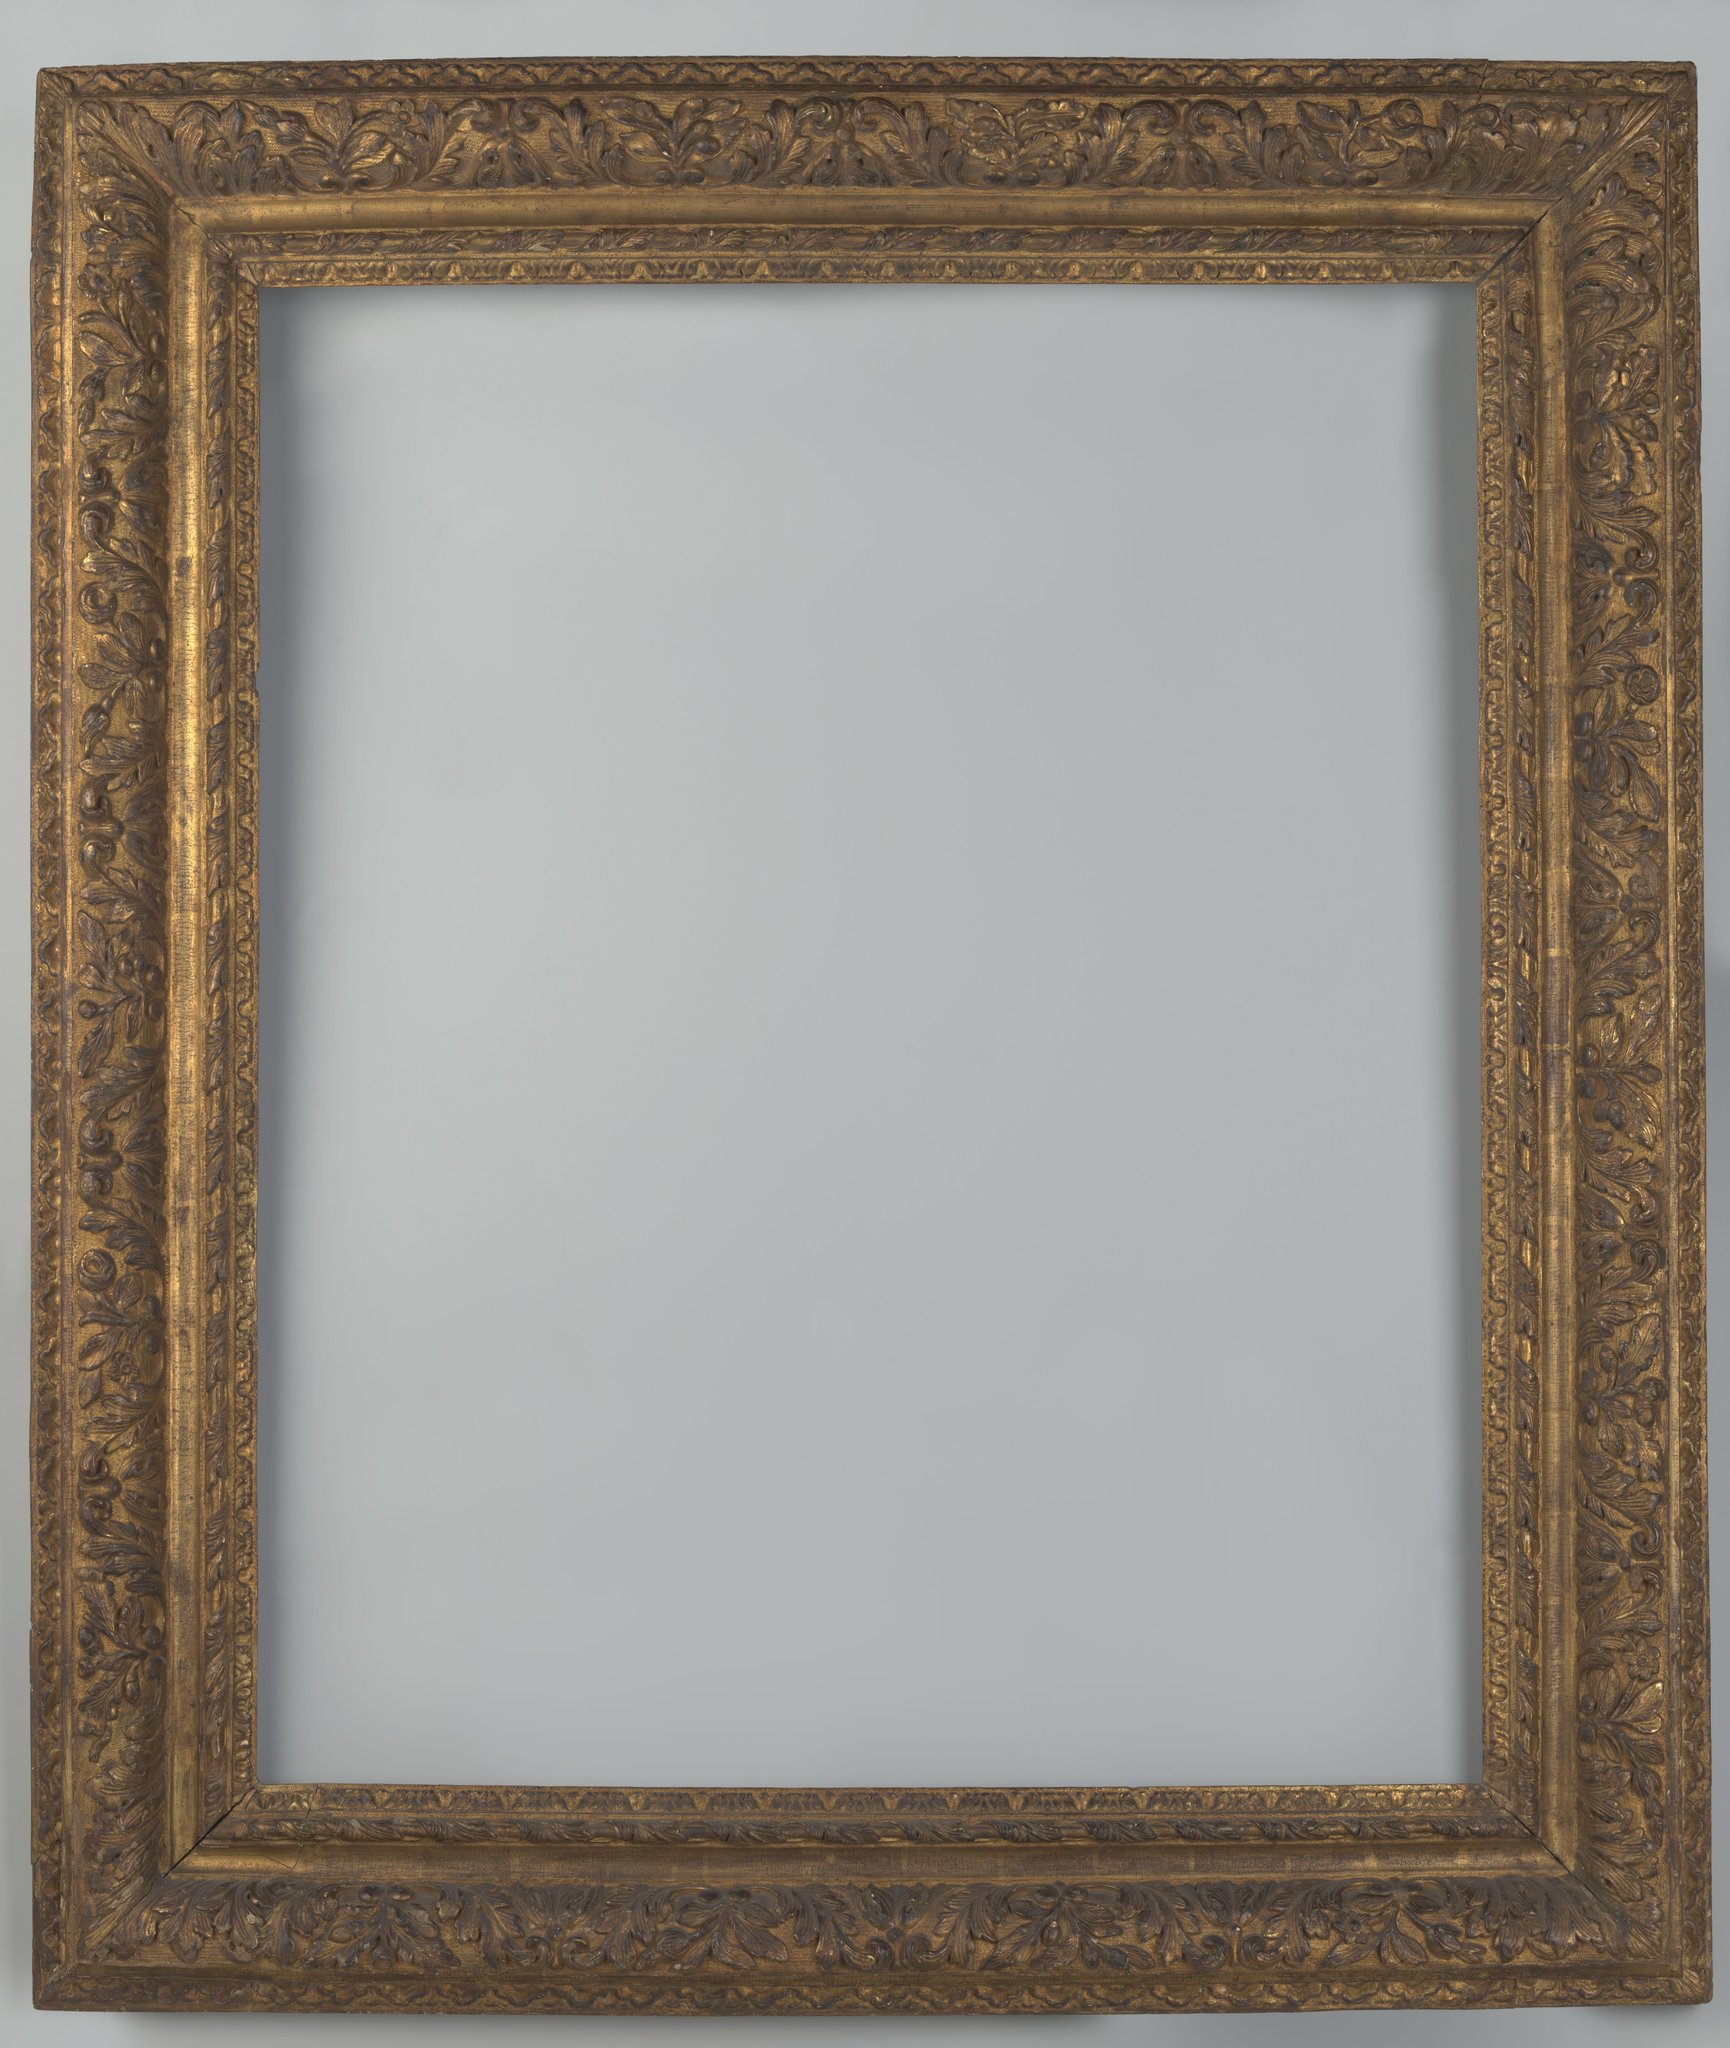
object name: frame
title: Vergulde Lodewijk XIII lijst met gesneden ornamenten uit lindenhout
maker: Anonymous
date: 1640-1660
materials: paint, gold leaf, wood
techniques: cutting, gilding, oil gilded, painting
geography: france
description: Vergulde Lodewijk XIII lijst met gesneden ornamenten. Op de buitenrand bestaat het snijwerk uit gestileerde bloem- en bladmotieven. De buitenrand grenst aan een bol profiel met een licht hollende rug. Het snijwerk hierop bestaat uit acanthusbladeren en bloemen. Aangrenzend een smalle koof en een gesneden lint met acanthusbladeren. De binnenrand is voorzien van een meer gestileerd bladmotief. In de grondering om het snijwerk is een ruitarcering aangebracht. Oorspronkelijk zijn de verstekken verbonden met zwaluwstaart spieën. De lijst is bij de boven- en onderregel versmald voor het schilderij, waarna een eikenhouten zool is aangebracht. De hoekverbindingen van de zool zijn eveneens verbonden met zwaluwstaart spieën.